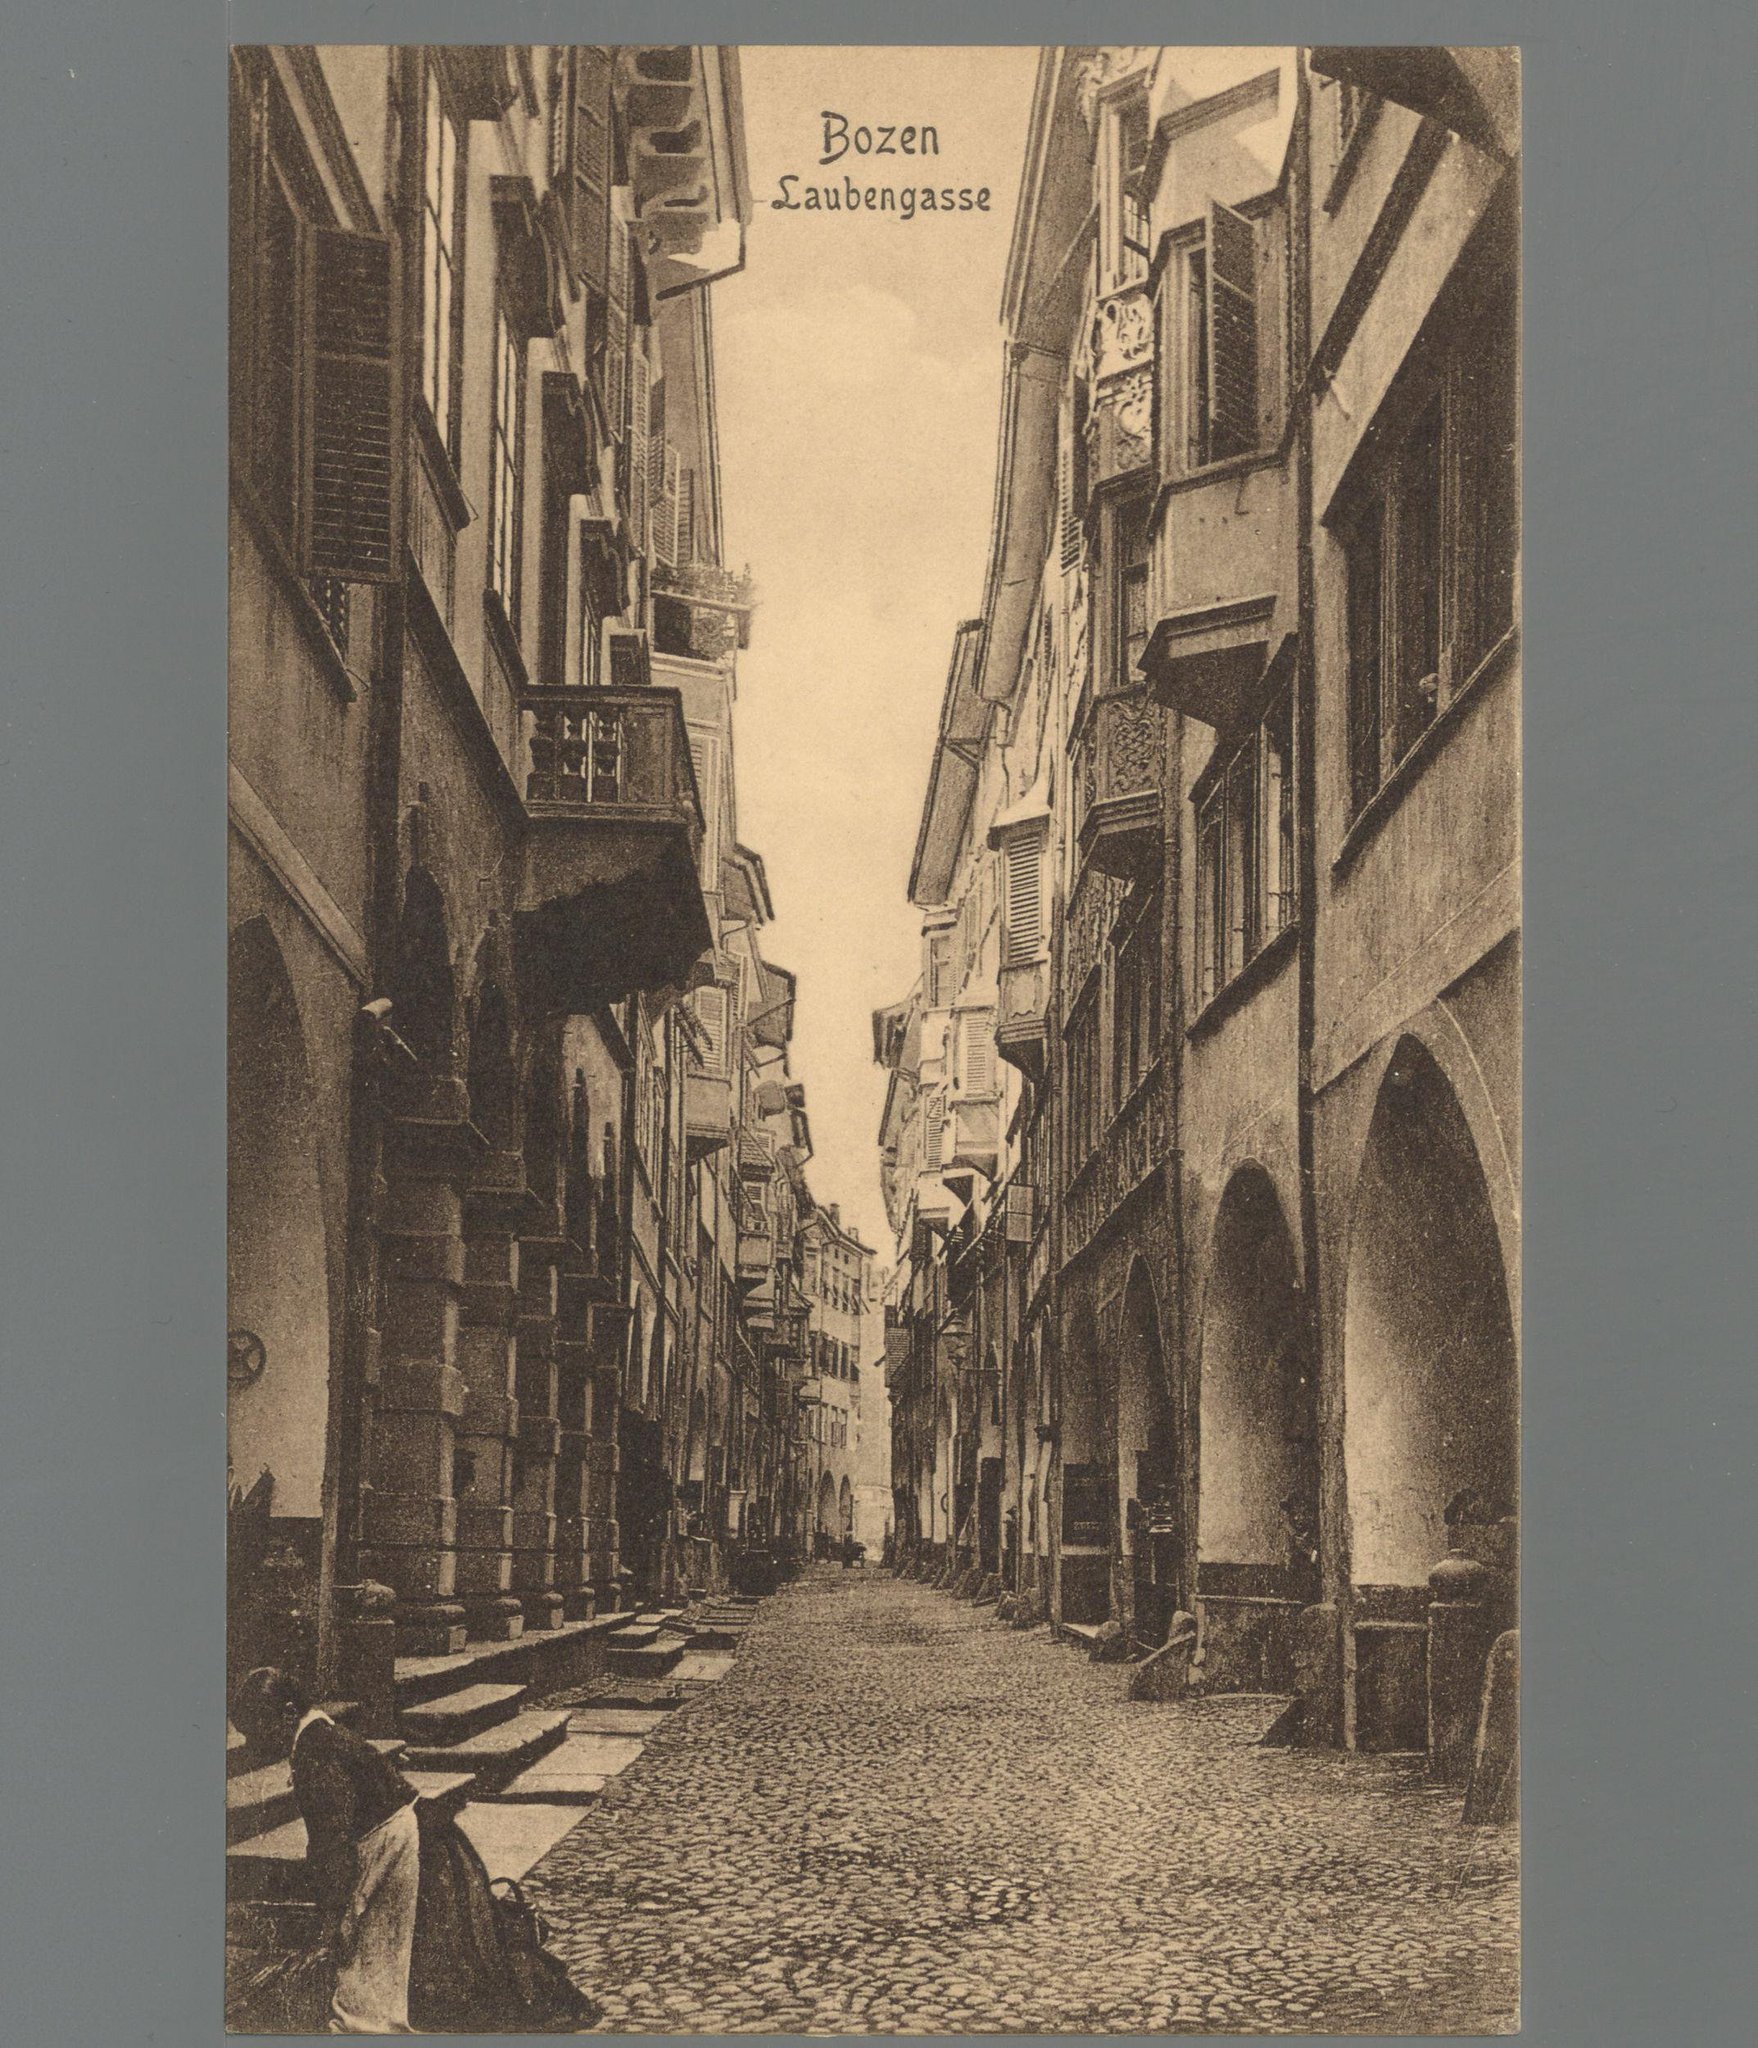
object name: photomechanical print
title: Bozen. Laubengasse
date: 1910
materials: cardboard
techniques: photograph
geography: bolzano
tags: street, street (+ city(-scape) with figures, staffage)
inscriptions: date